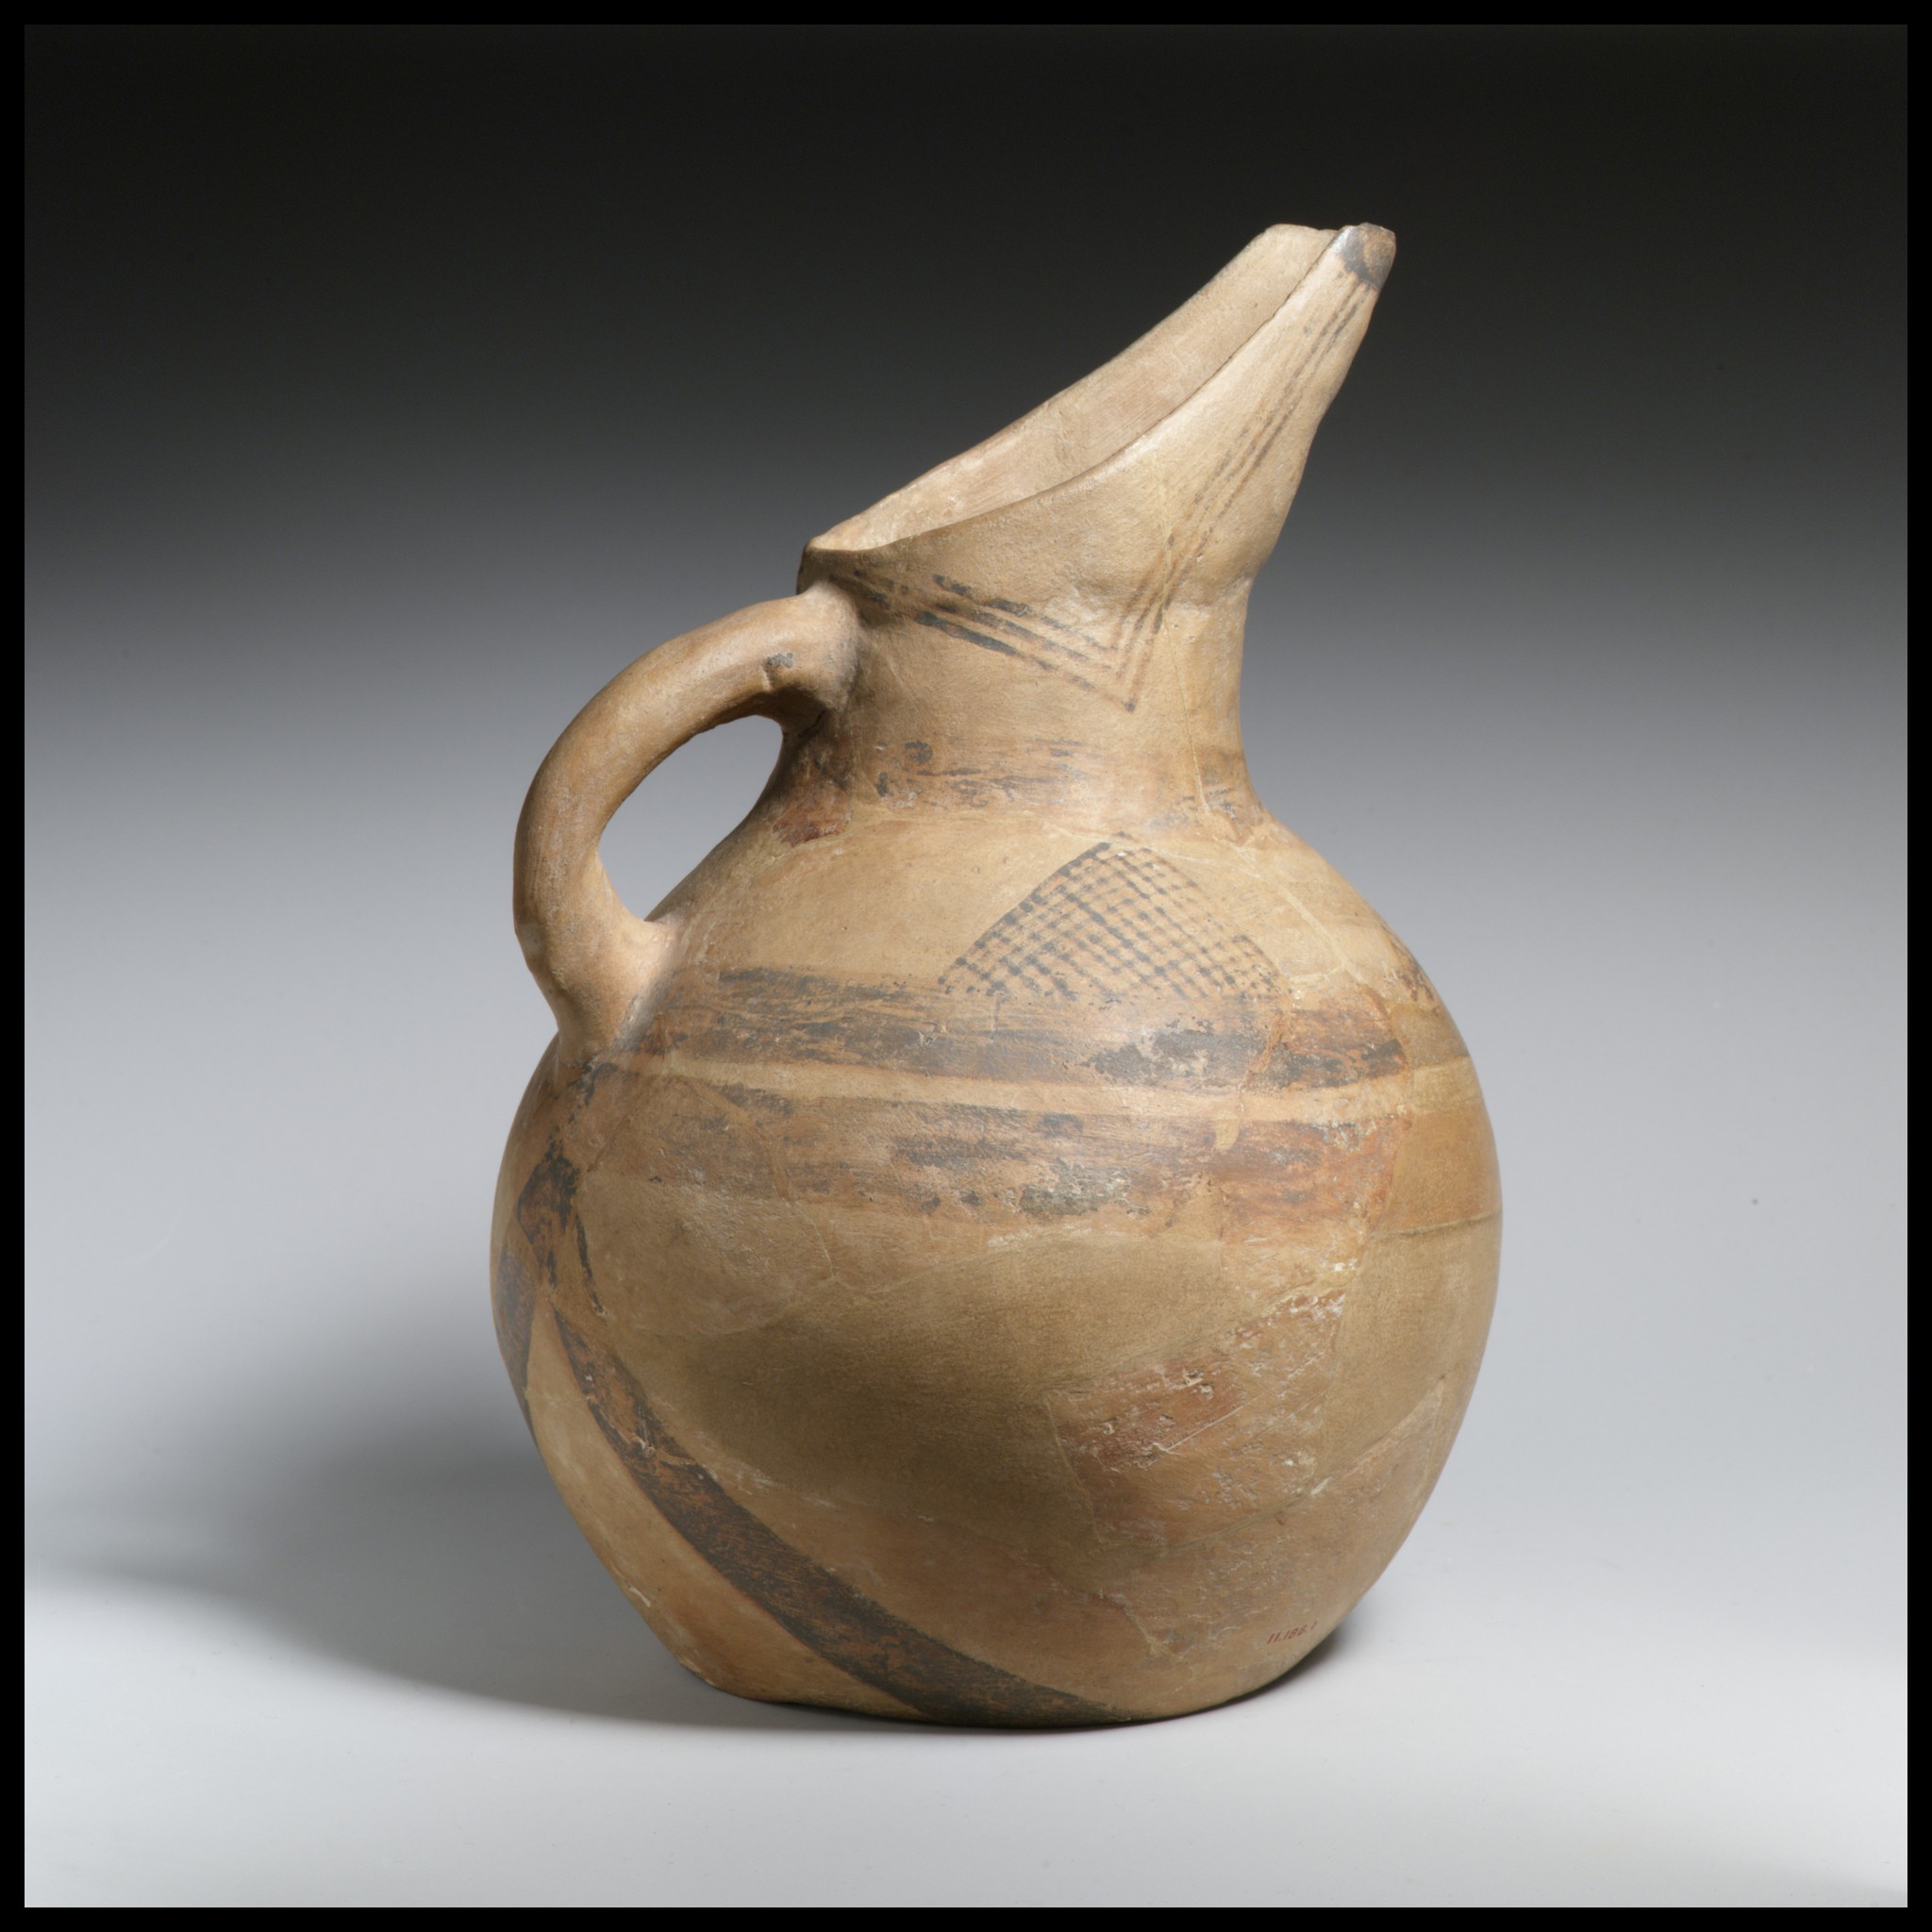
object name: jug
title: Terracotta jug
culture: minoan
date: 2900-2300 BCE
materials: terracotta